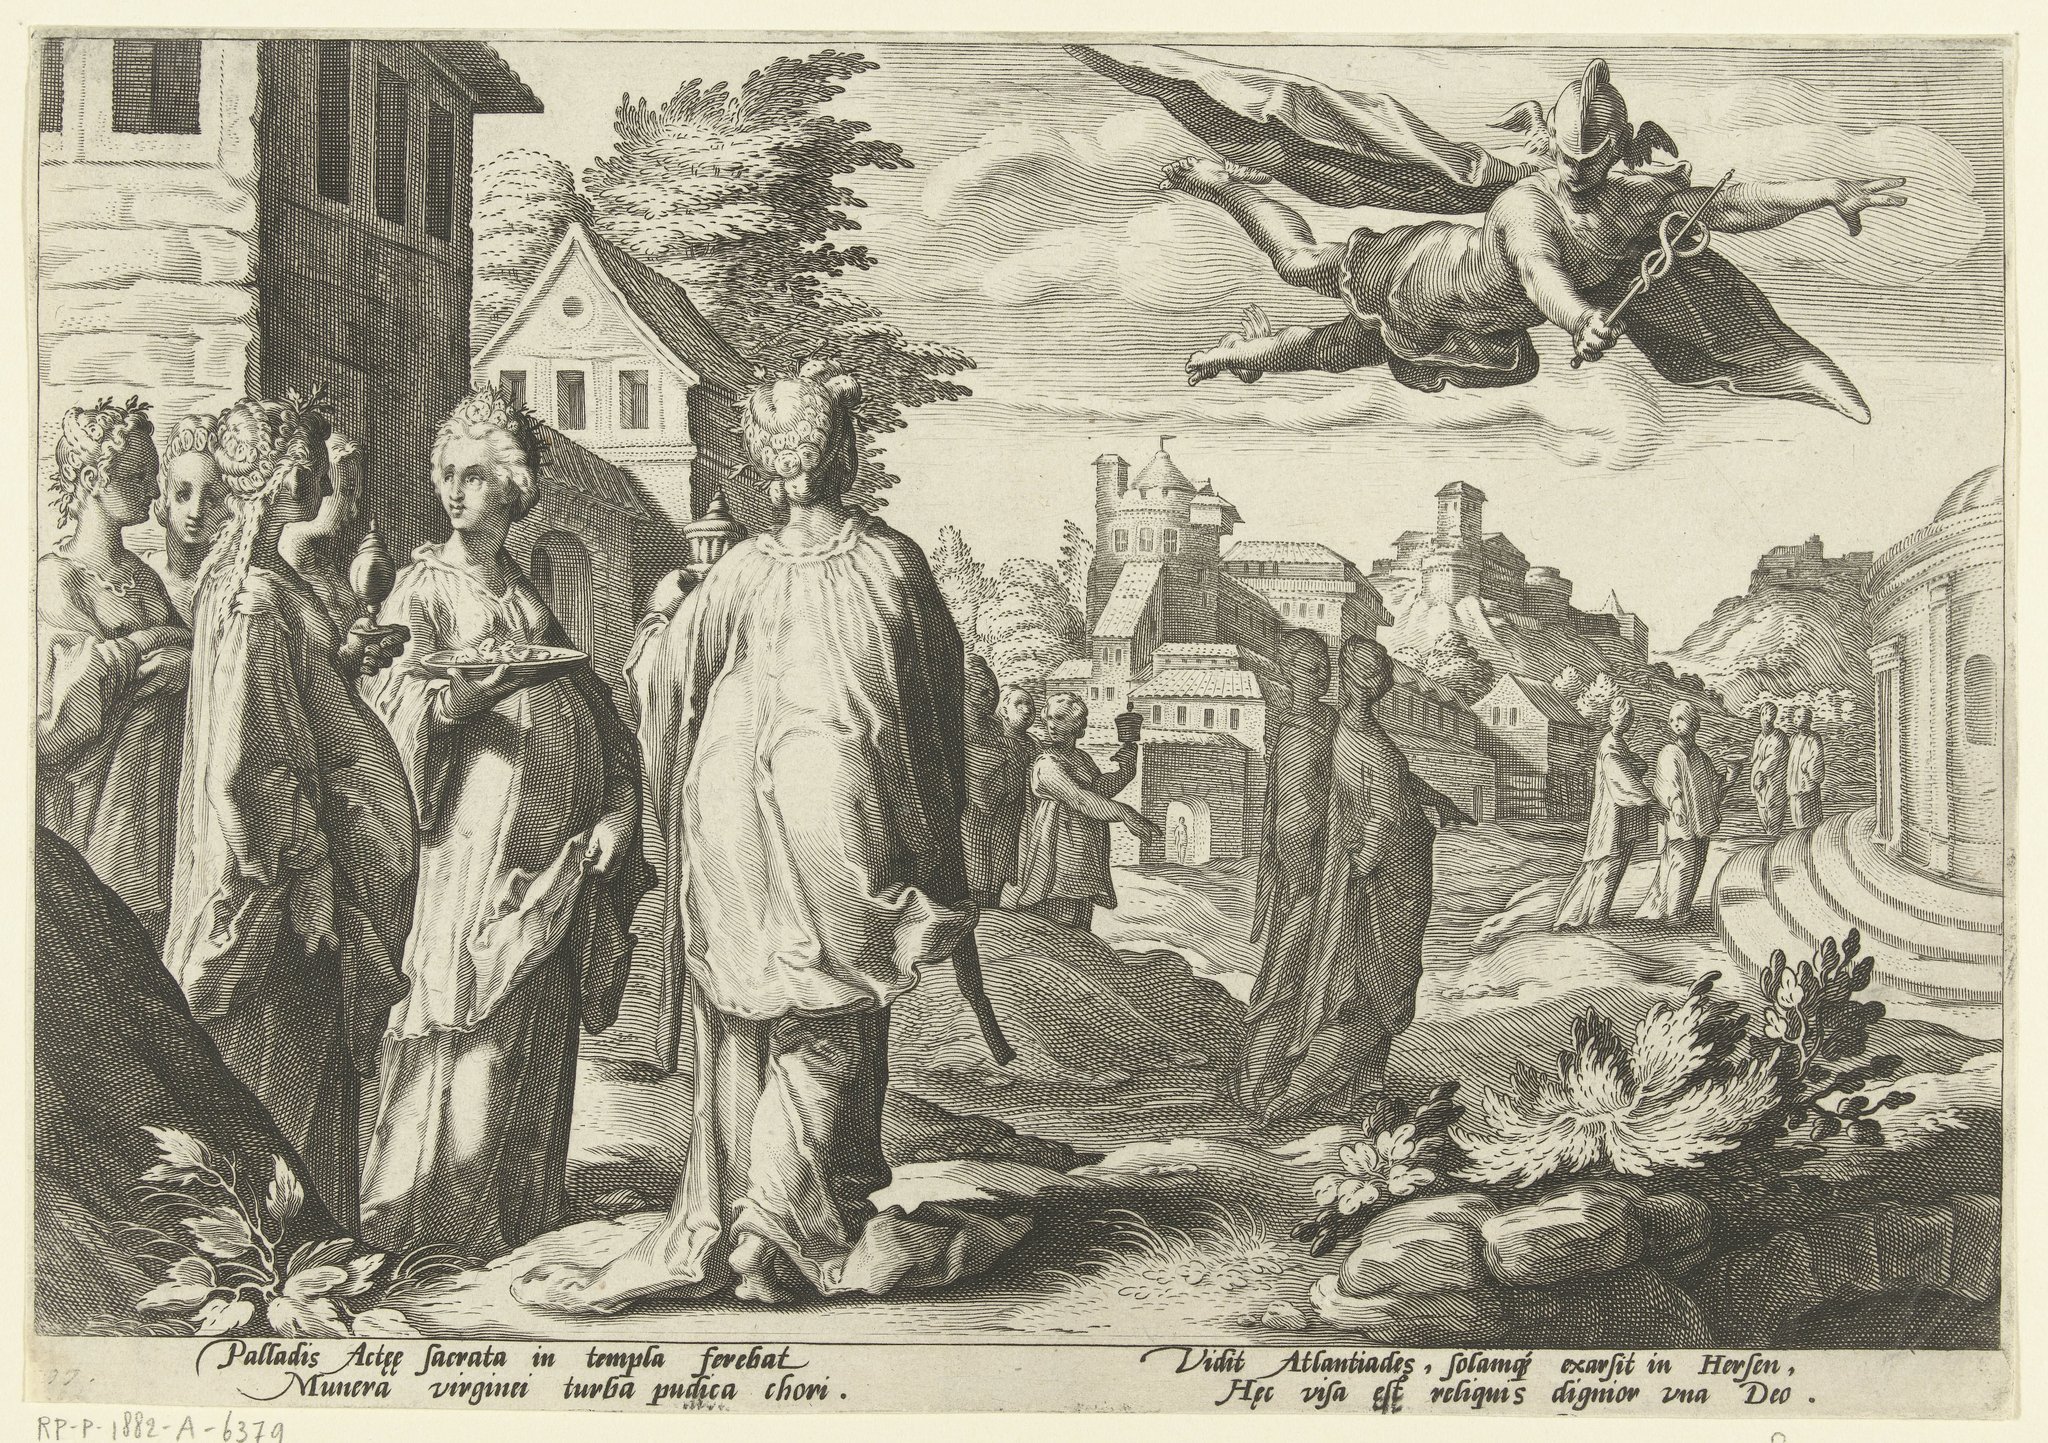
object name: print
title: Mercurius wordt verliefd op Herse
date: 1590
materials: paper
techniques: engraving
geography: haarlem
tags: mercury falls in love with herse, when seeing her and her companions carry baskets full of flowers to the temple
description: Mercurius bespiedt de dochters van Cecrops, als zij terugkeren van het feest van Minerva, en wordt verliefd op de mooiste van hen, Herse. Onder de voorstelling twee keer twee regels Latijnse tekst. Deze prent is onderdeel van een serie van 52 prenten die verhalen uit Ovidius' Metamorfosen verbeelden. Deze serie valt uiteen in drie genummerde reeksen: twee van 20 prenten en één van 12 prenten. Deze prent behoort tot de tweede reeks.